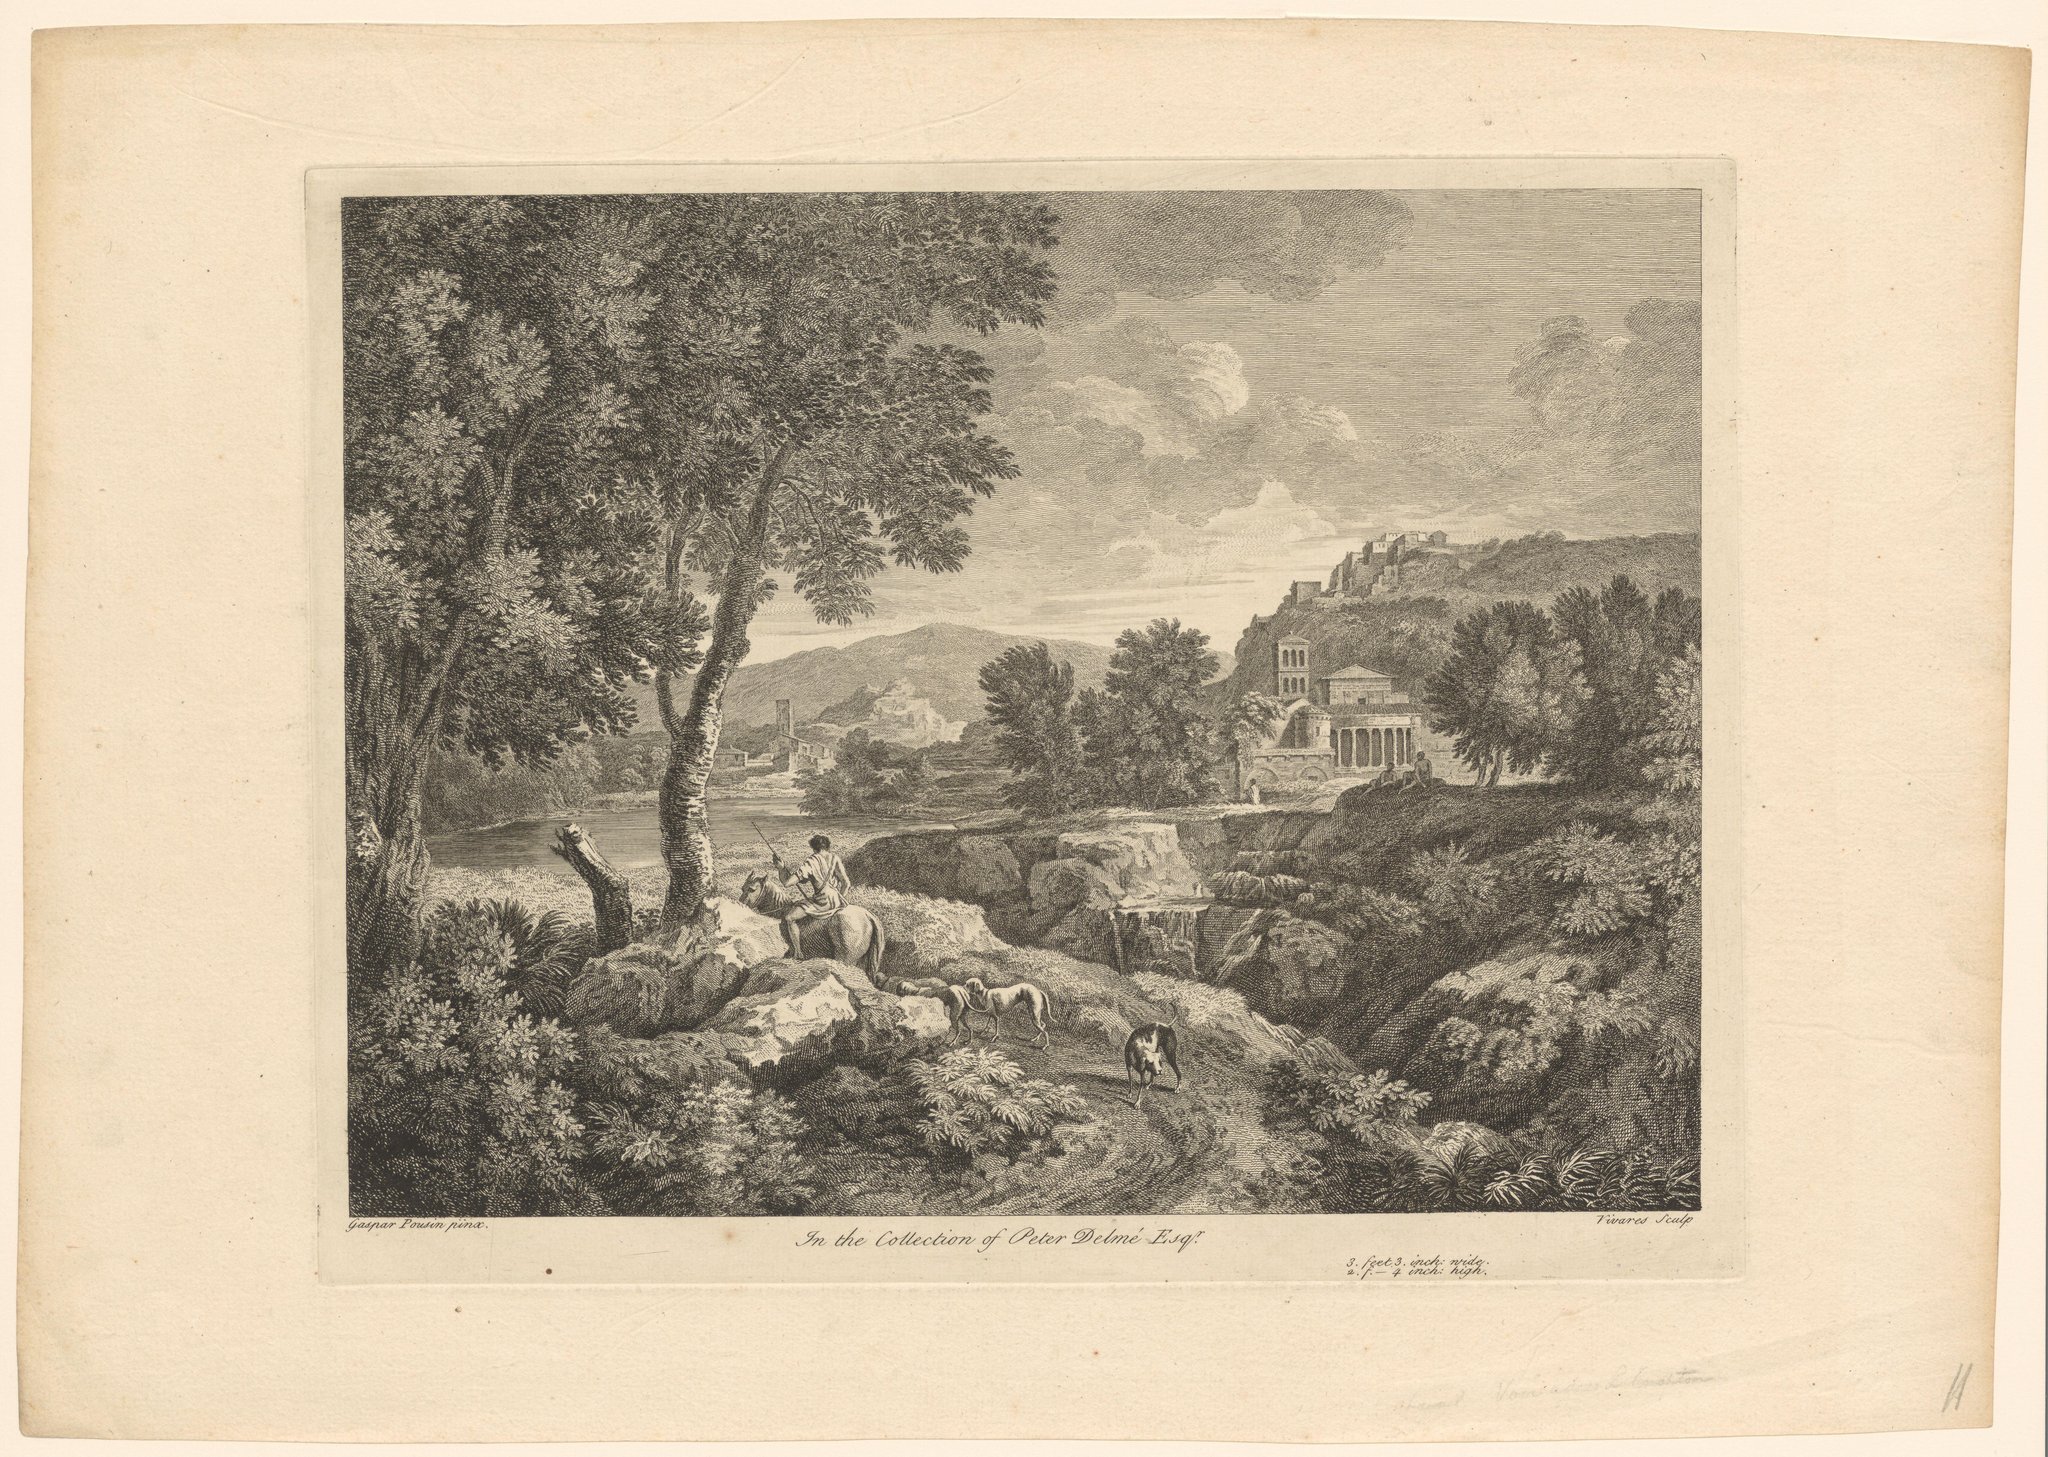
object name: print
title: Landschap met dorpen langs een rivier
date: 1719-1741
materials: paper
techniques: etching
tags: prospect of village, silhouette of village, 'en route', traveller under way, river (+ landscape with figures, staffage)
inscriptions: collector's mark: Lugt 2228